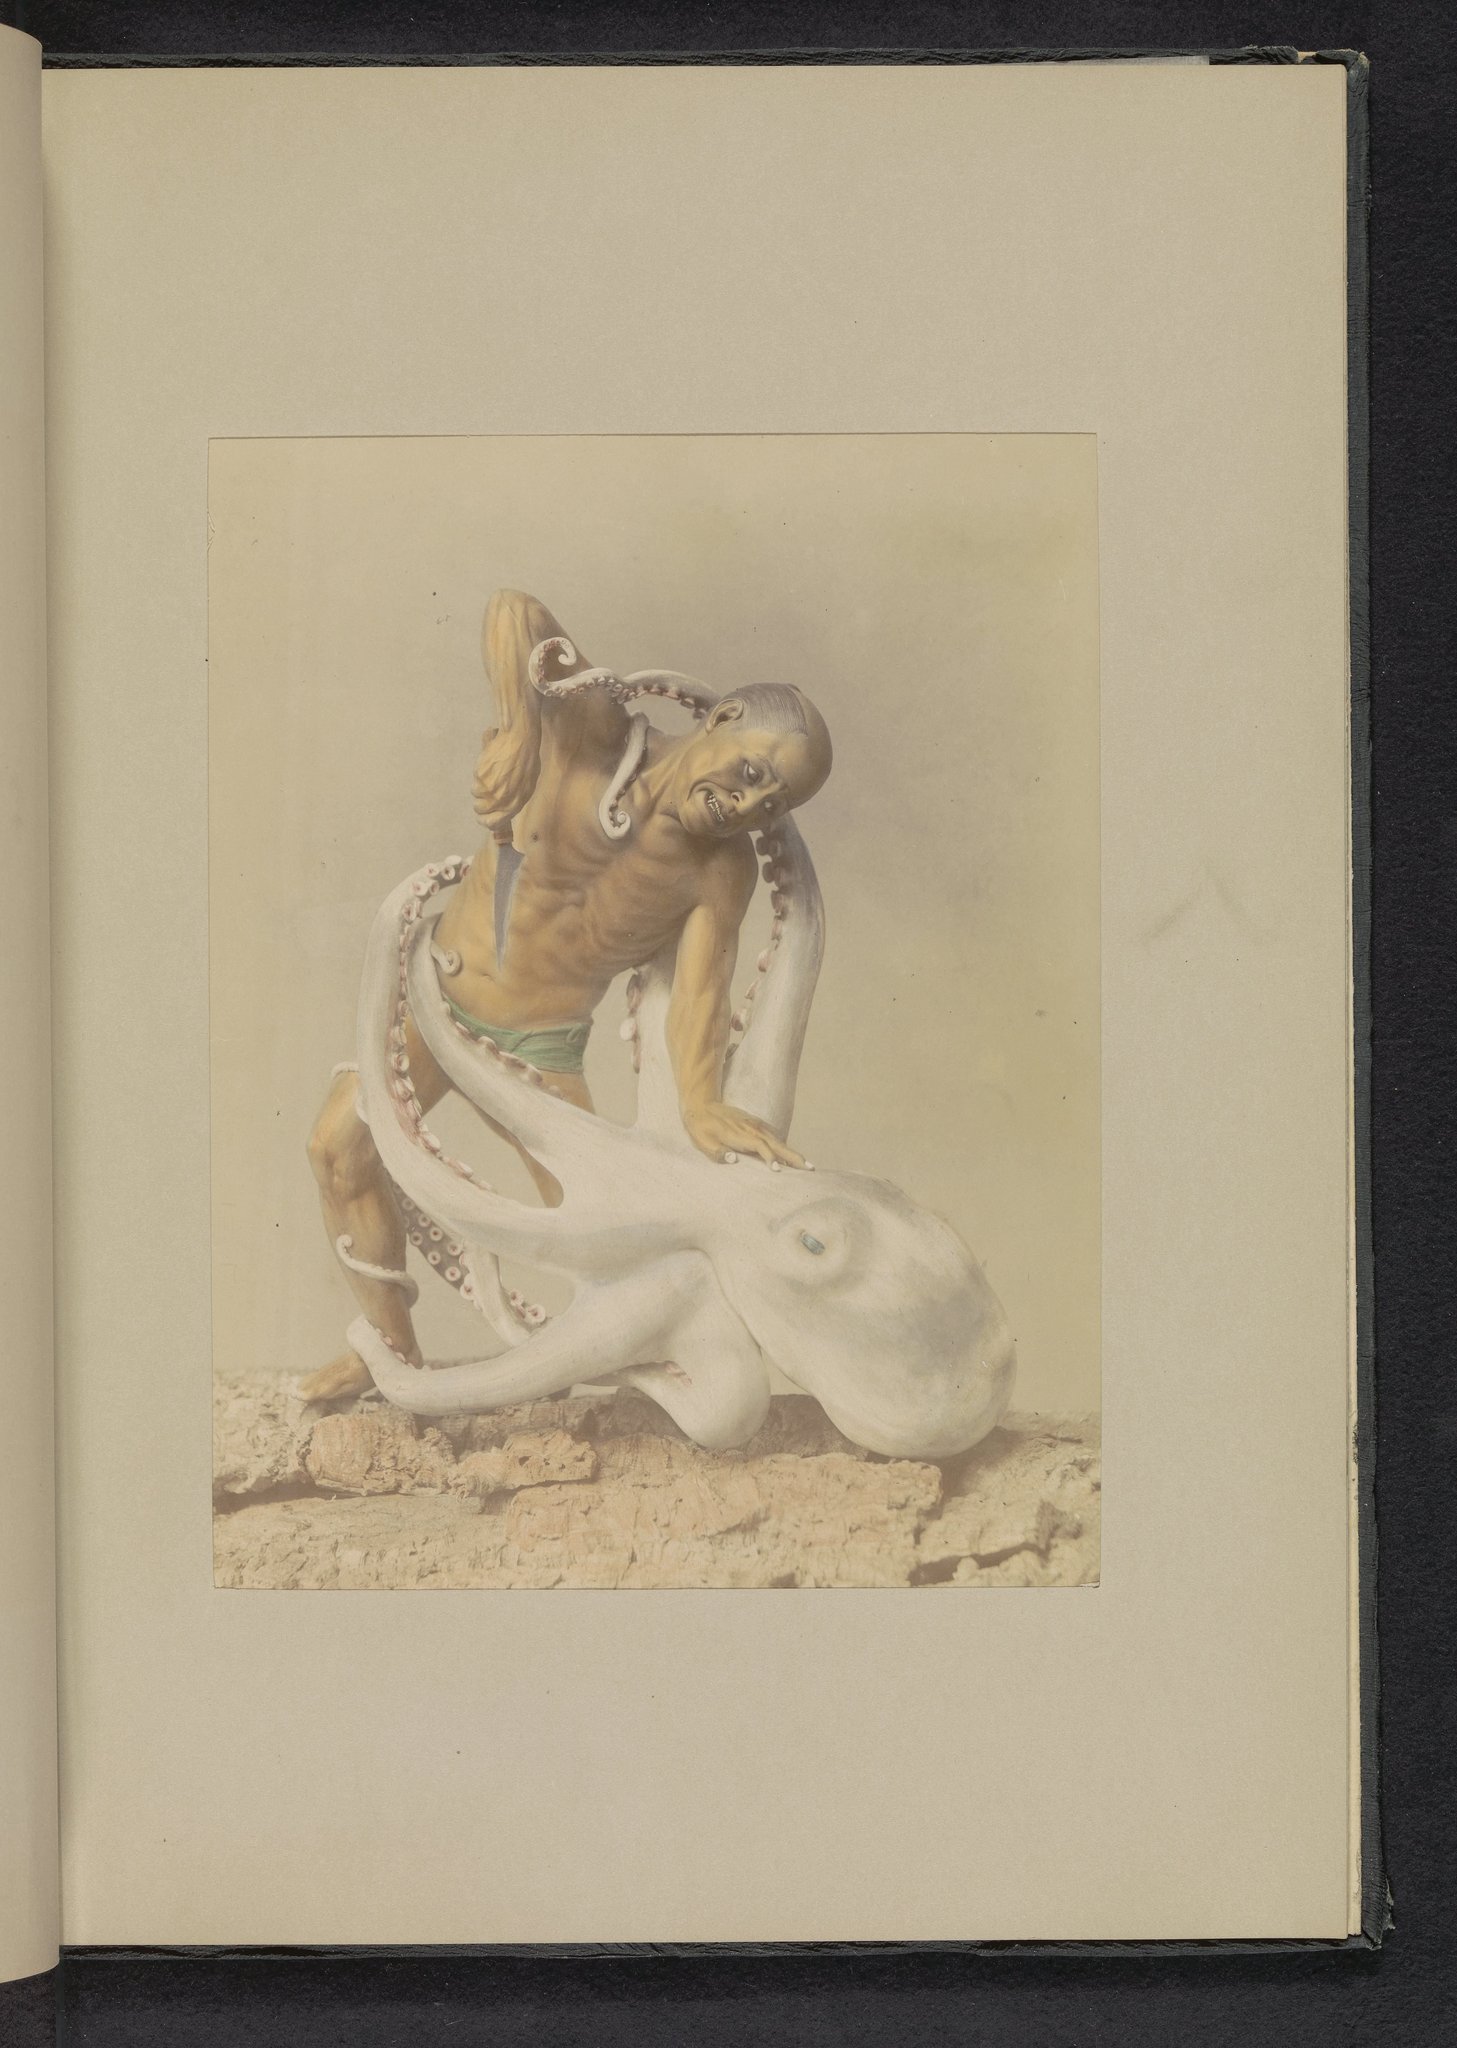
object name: photograph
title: Houtsnijwerk van een man in gevecht met een octopus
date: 1887-1897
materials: photographic support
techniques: albumen print, hand coloring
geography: japan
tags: molluscs: octopus, sculpture, fighting